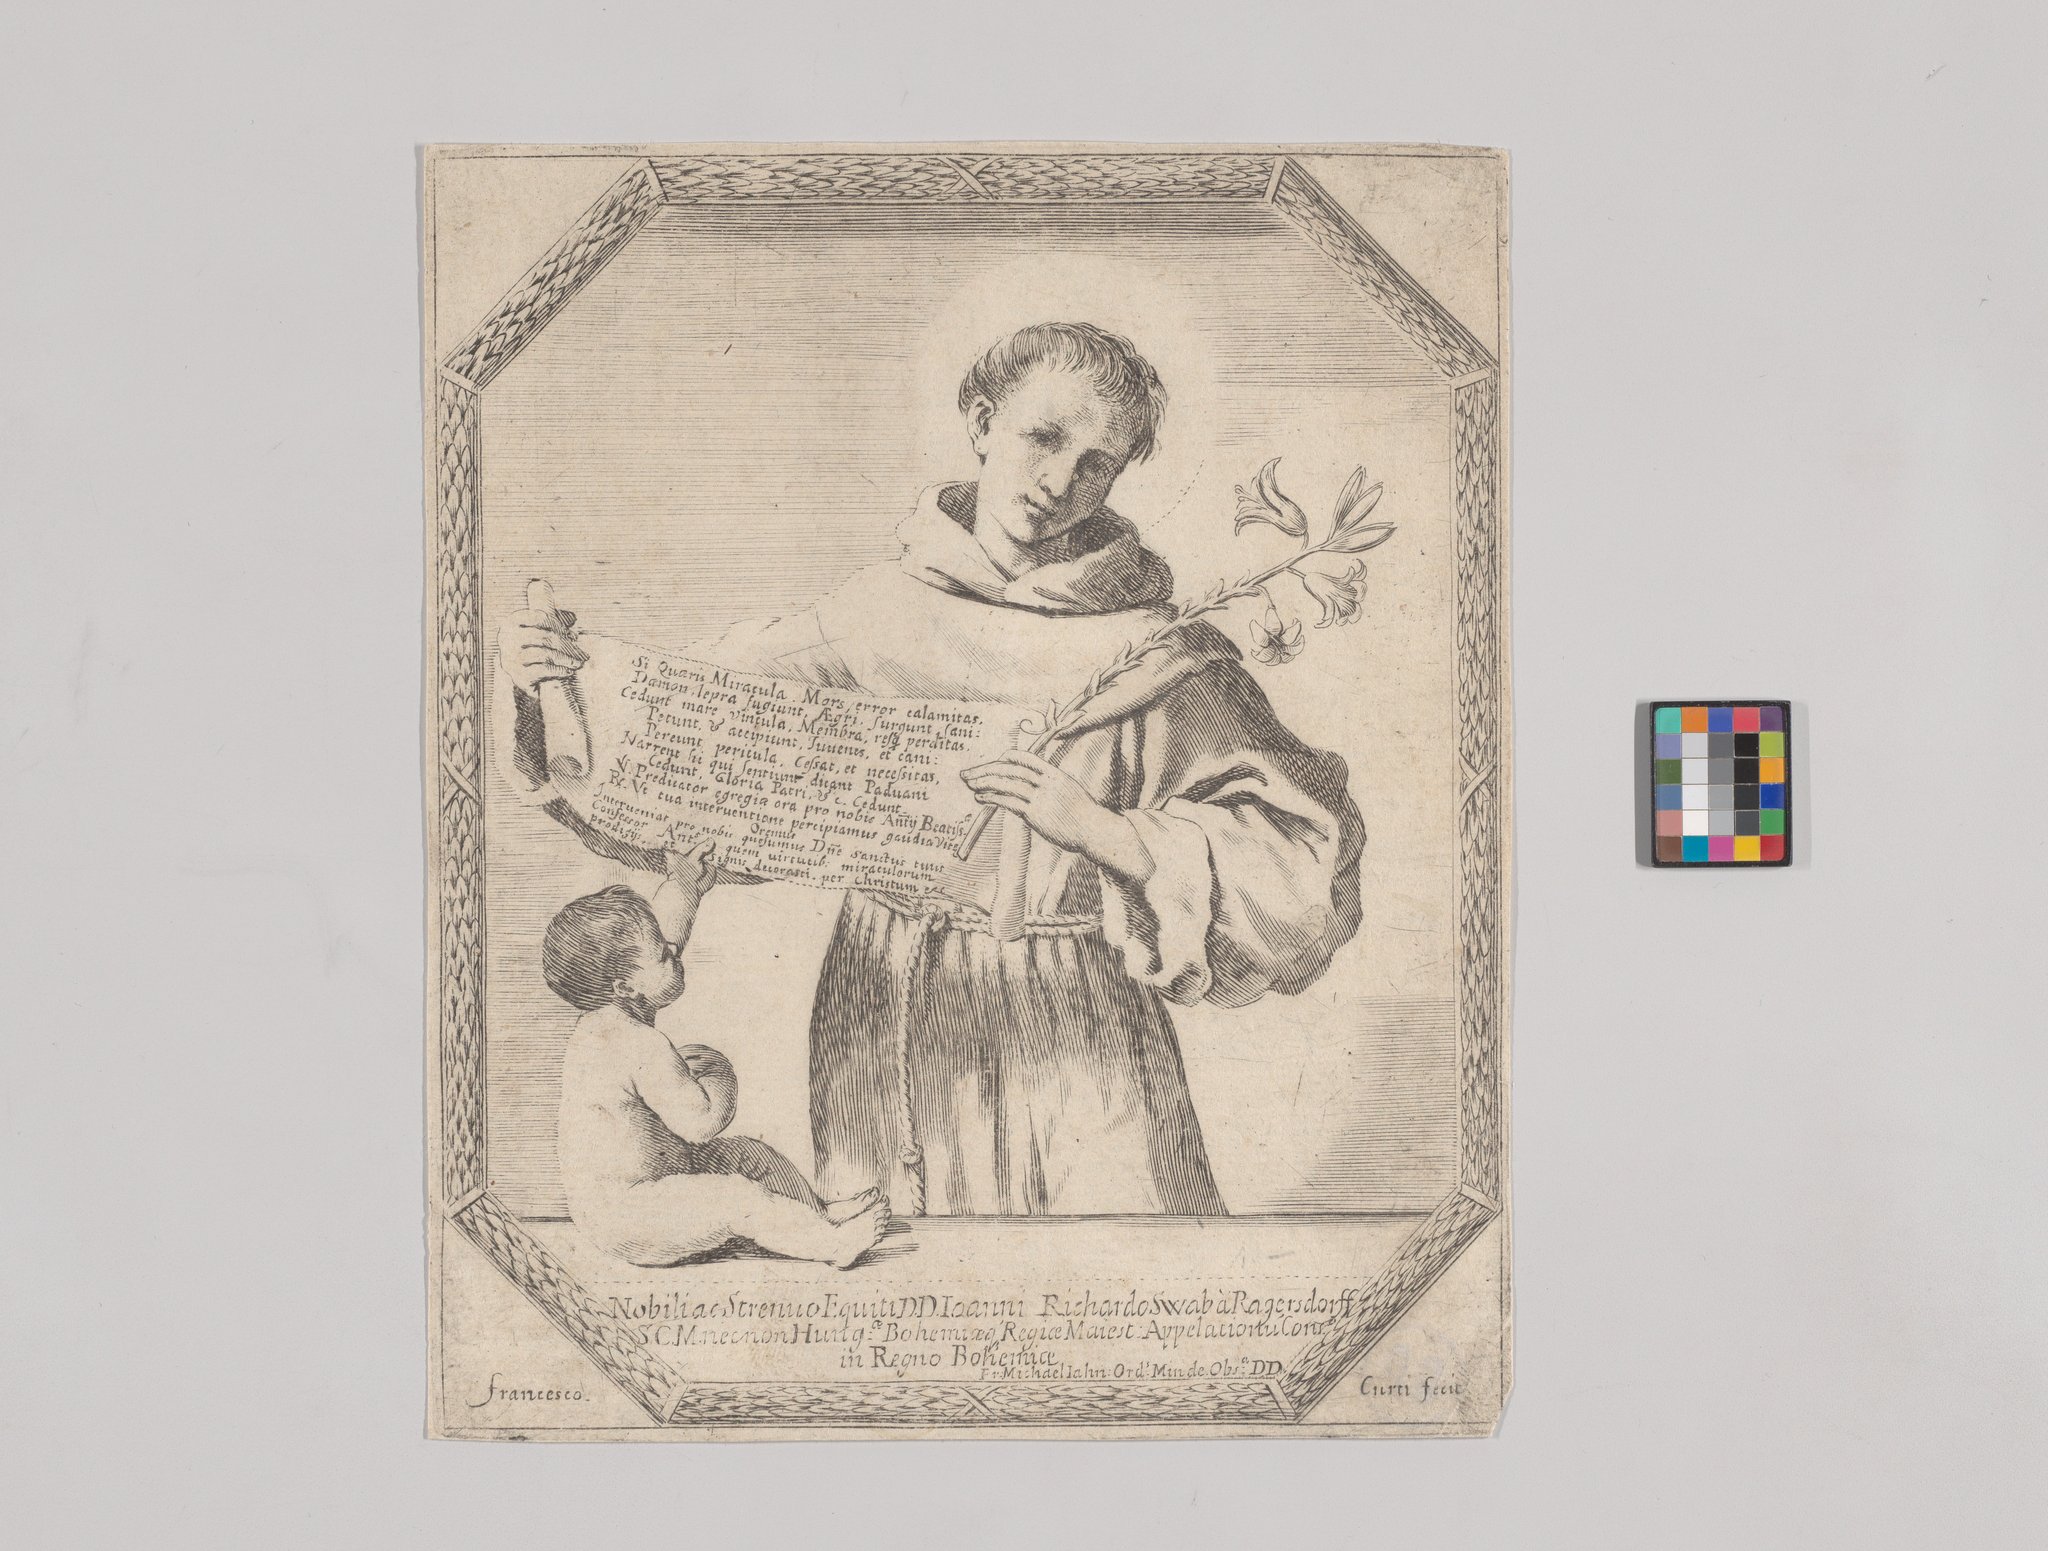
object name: print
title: Saint Anthony of Padua holding a lily and a scroll, with an infant at lower left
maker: francesco curti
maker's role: artist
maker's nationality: italian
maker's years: 1603-1670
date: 1633-1670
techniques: engraving, etching